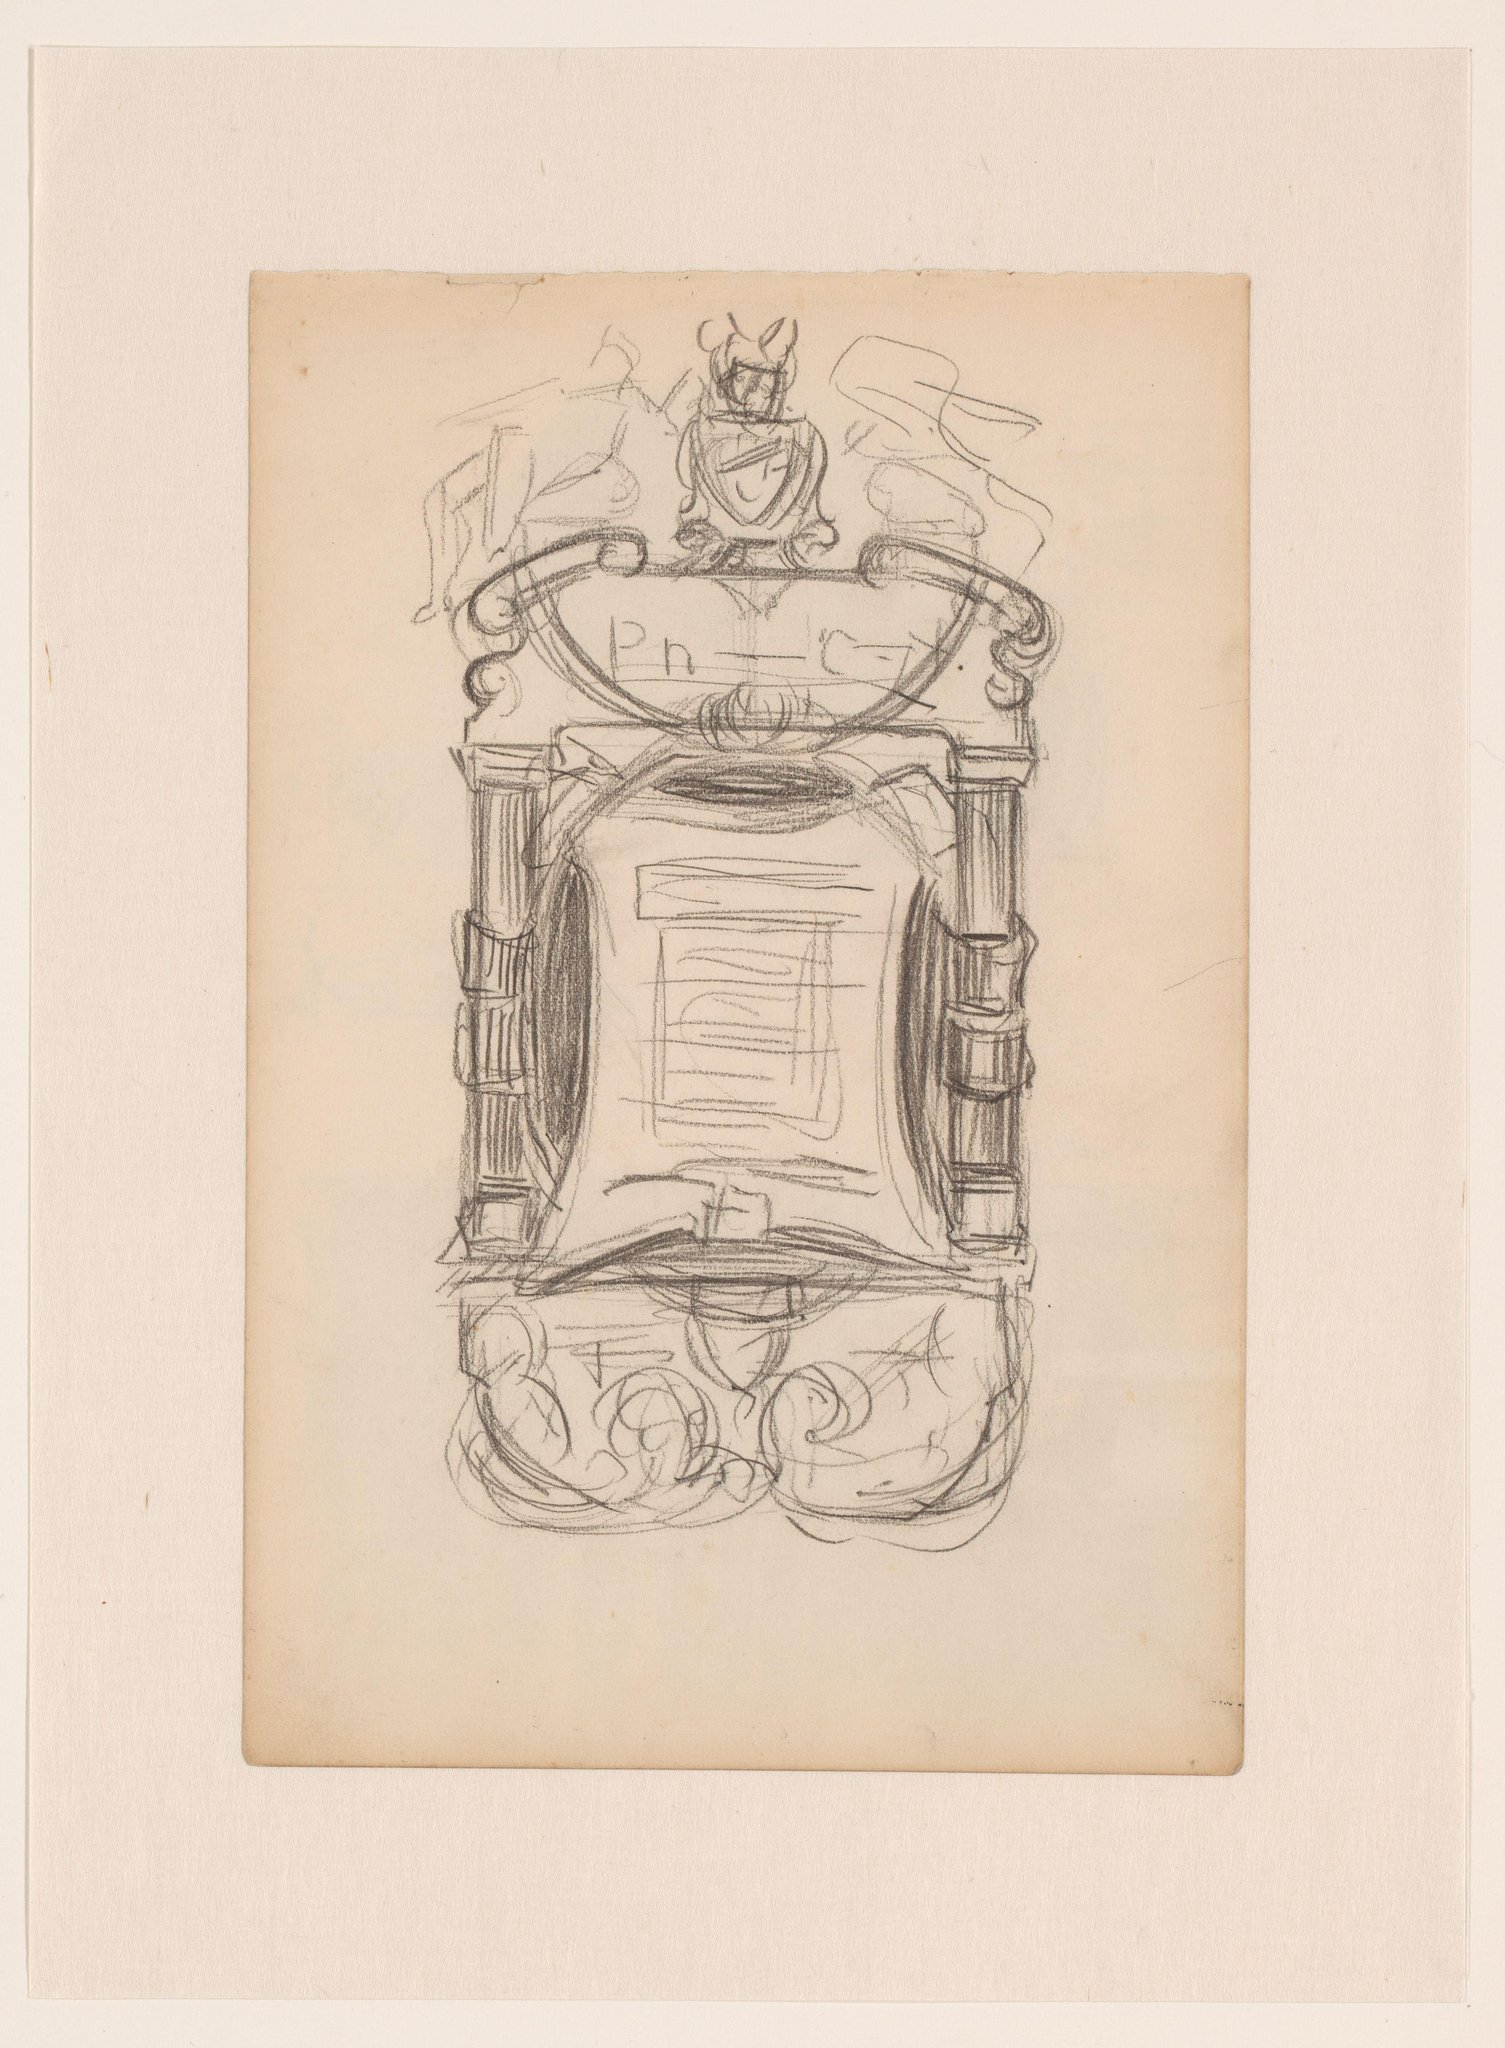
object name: design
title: Ontwerp voor een prijslijst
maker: ernst maximilian büttinghausen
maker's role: draughtsman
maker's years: 1883-1929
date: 1900-1902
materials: paper, pencil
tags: frame of painting, etc.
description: Zeer waarschijnlijk ontworpen voor het atelier van zijn vader Max Büttinghausen.